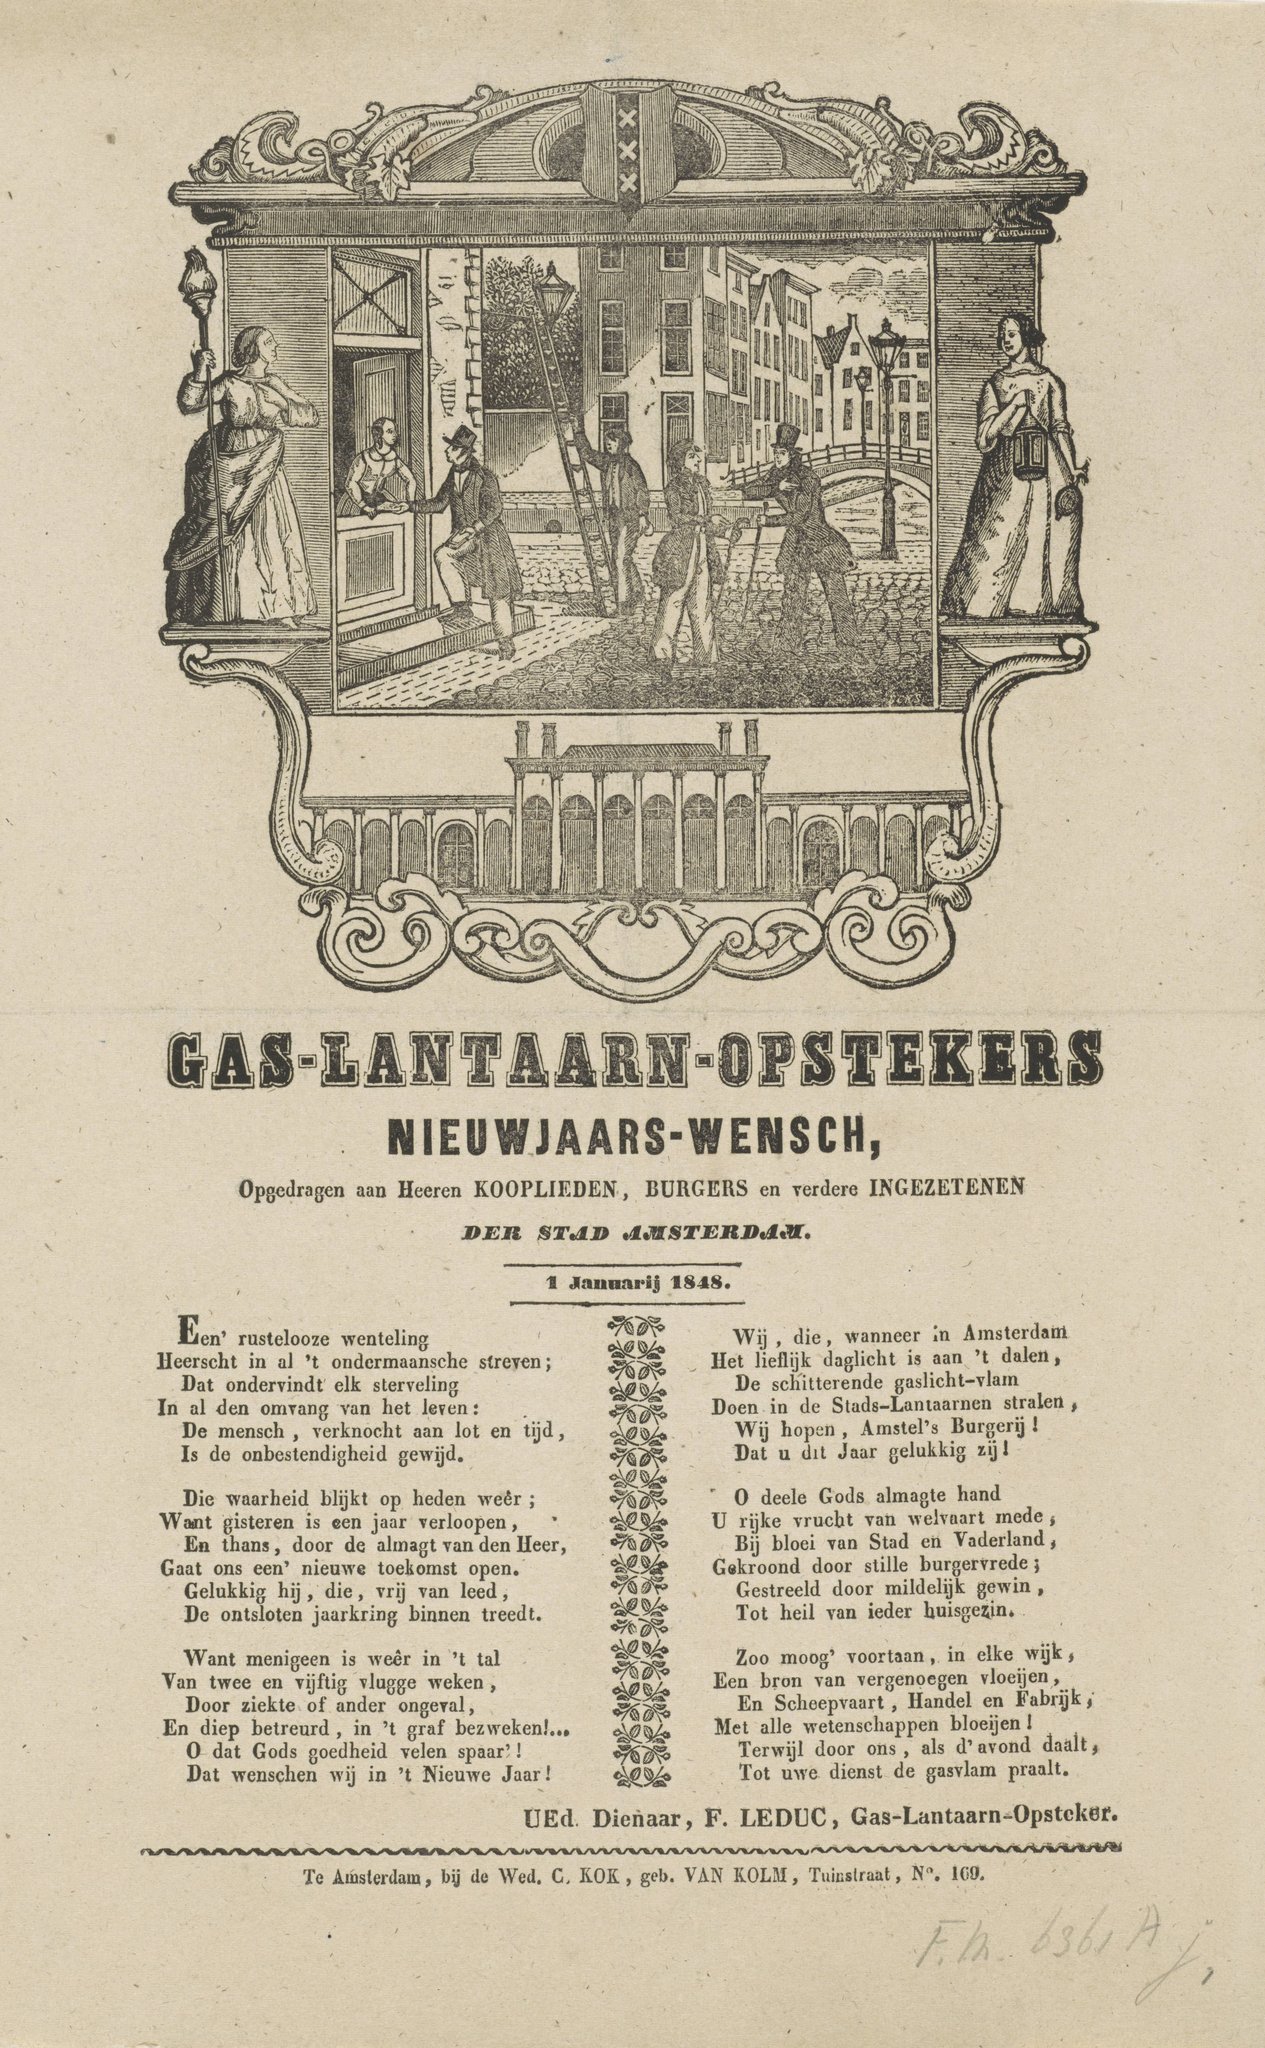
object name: new year card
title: Nieuwjaarswens van de gaslantaarnopstekers van Amsterdam voor het jaar 1848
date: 1847-1848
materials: paper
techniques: letterpress printing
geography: amsterdam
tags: gas-lamp (+ kindling a light; lit, burning light, lamp, candle), street lighting, street, amsterdam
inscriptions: collector's mark: Lugt 2228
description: Nieuwjaarswens van de Amsterdamse gaslantaarnopstekers voor het jaar 1848. Cartouche met een gezicht in een straat in Amsterdam waar enkele mannen bezig zijn de straatlantaarns aan te steken. Een andere man haalt geld op bij een huis. Links en rechts een staande vrouw met een fakkel en een olielantaarn, onderaan de Amsterdamse gasfabriek. Met gedicht in twee kolommen. Van de gaslantaarnopsteker: F. Leduc.